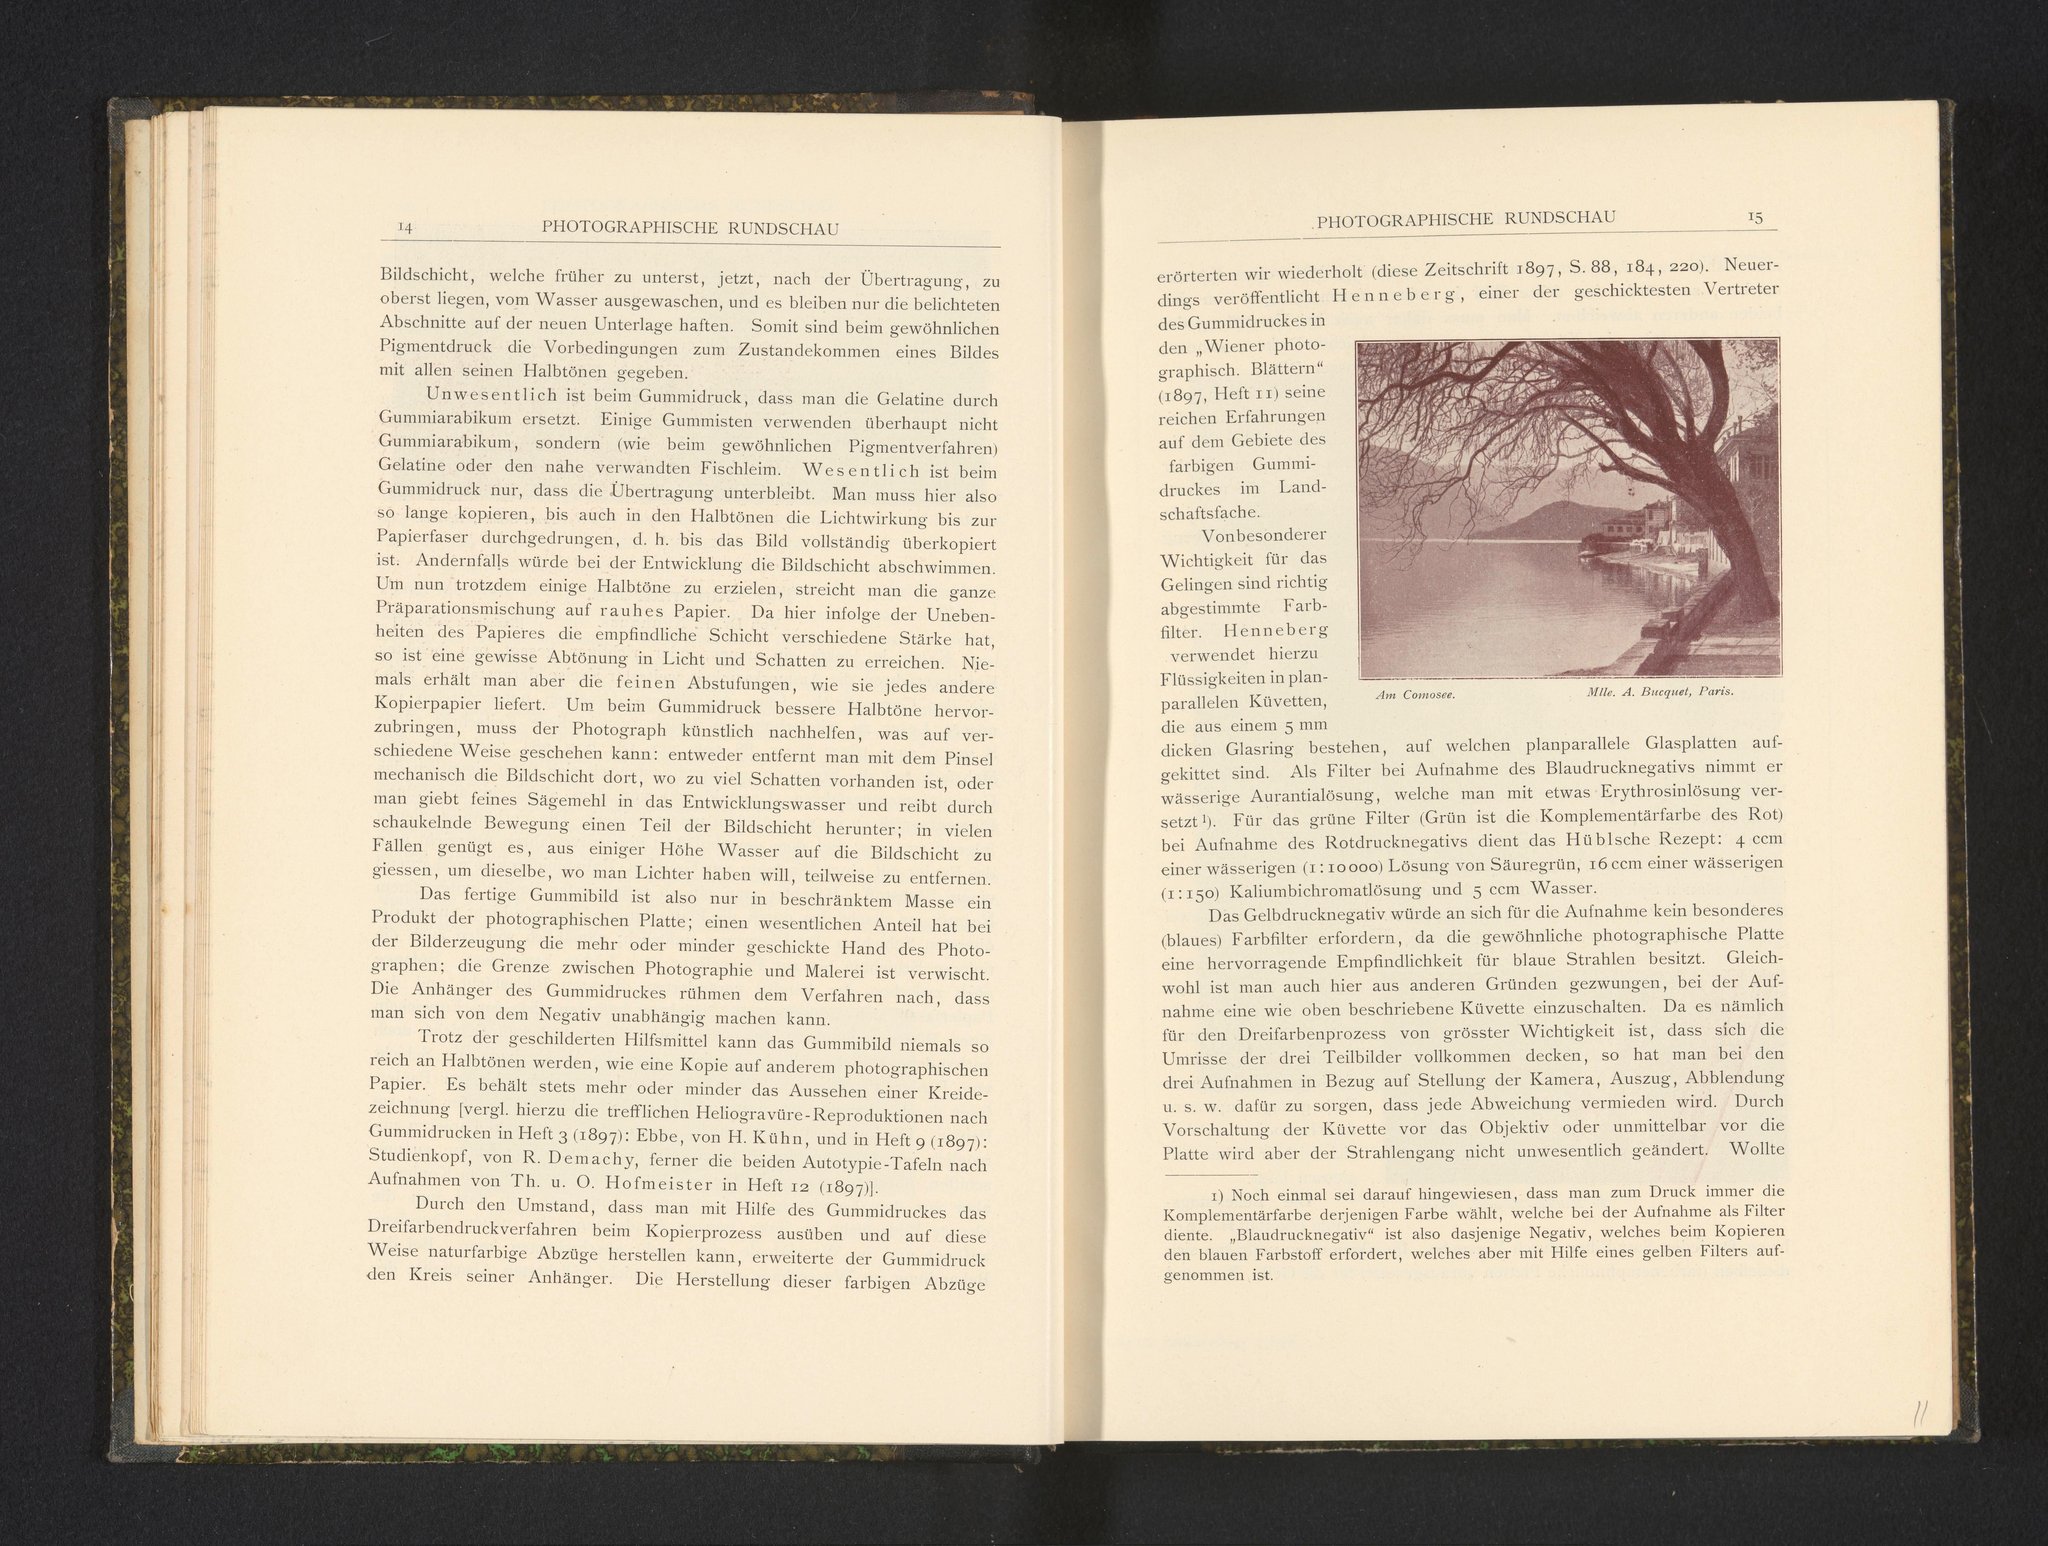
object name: page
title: Gezicht op het Comomeer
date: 1893-1898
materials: paper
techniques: autotype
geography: lombardy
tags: lake